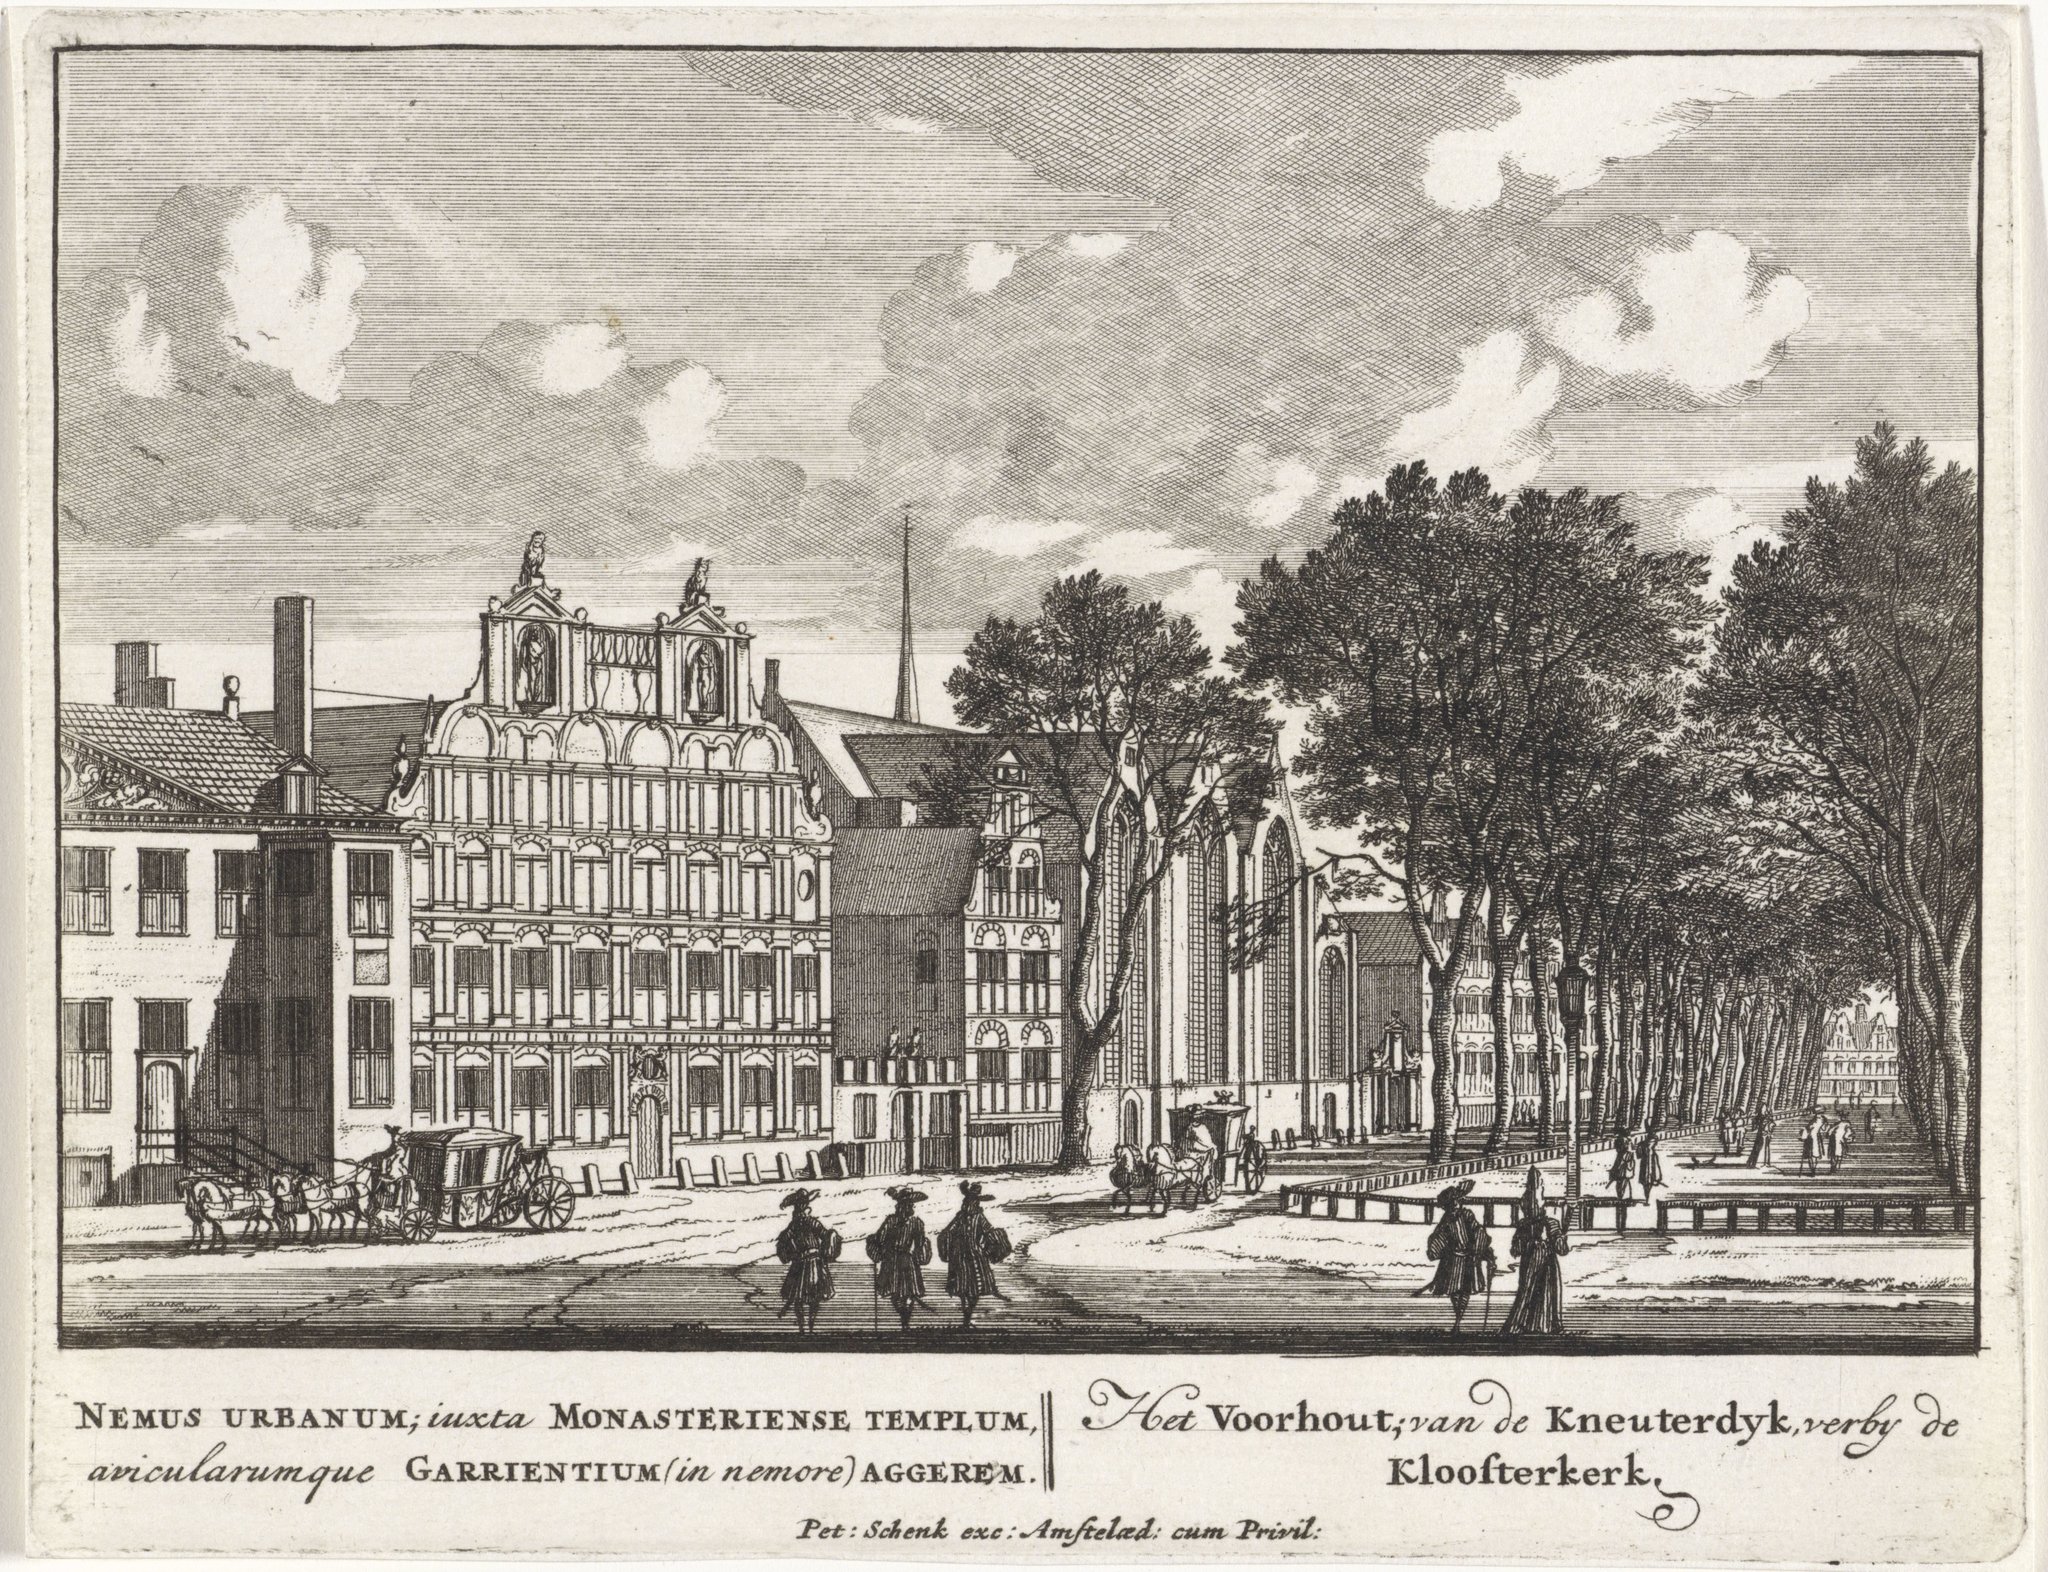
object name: print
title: Gezicht op de Kneuterdijk en het Lange Voorhout te Den Haag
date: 1686-1711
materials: paper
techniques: etching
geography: amsterdam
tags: church (exterior), street (+ city(-scape) with figures, staffage)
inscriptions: collector's mark: Lugt 2228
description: Gezicht op de Kneuterdijk, met het voormalige woonhuis van Johan van Oldenbarnevelt (tweede van links), die overloopt in het Lange Voorhout met de Kloosterkerk. Prent uit een serie van zeventien gezichten in Den Haag en omgeving.